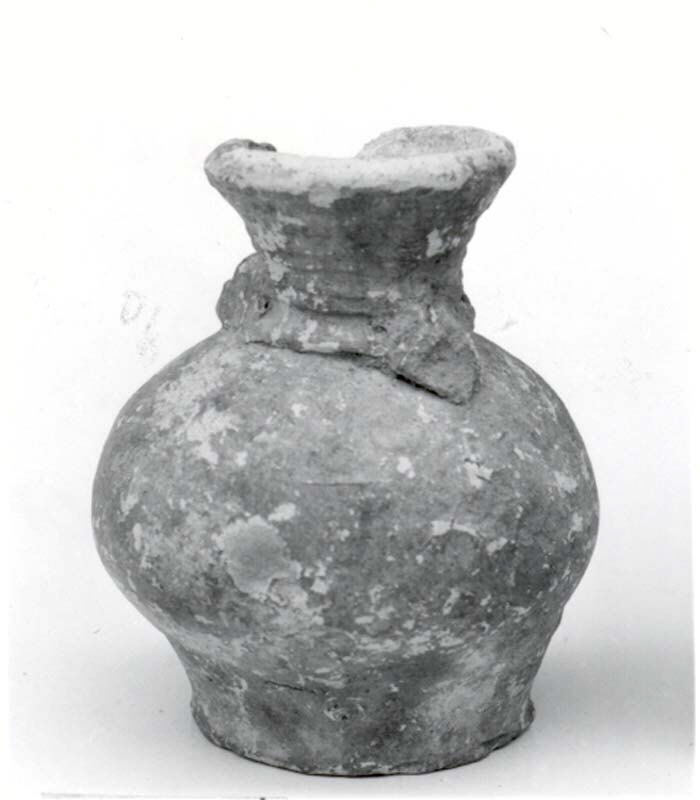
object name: jar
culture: sasanian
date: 201-700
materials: ceramic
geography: mesopotamia